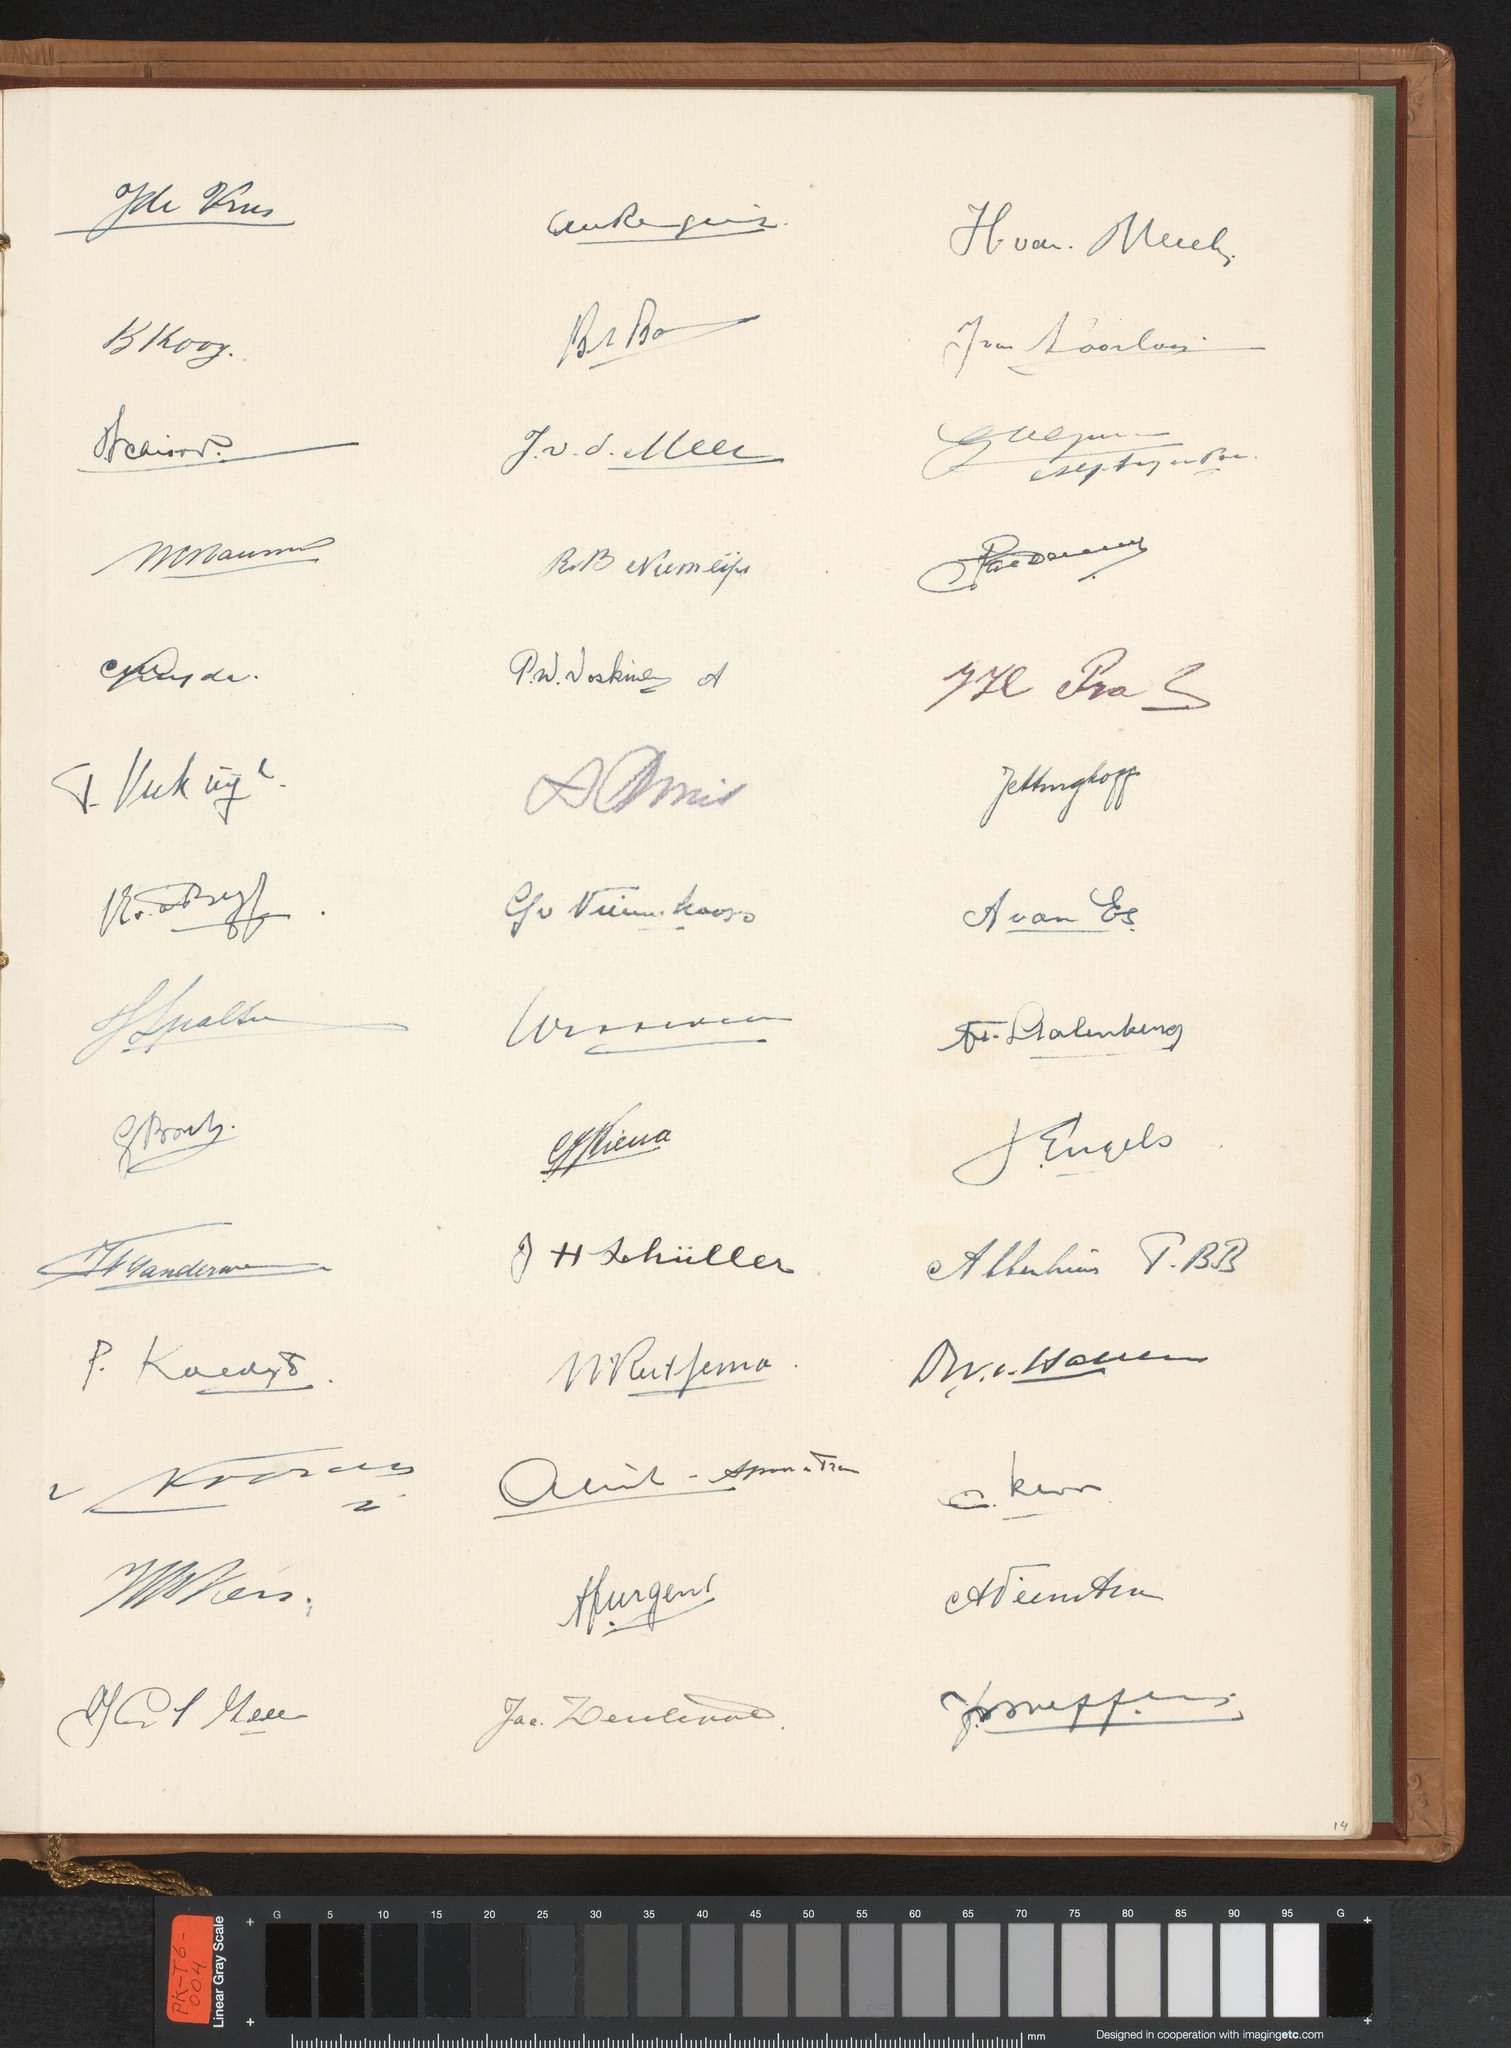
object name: text sheet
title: Blad met handtekeningen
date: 1949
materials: ink, paper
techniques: handwriting, pen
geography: netherlands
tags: modern professional organization, trade union, reception, cocktail party, handwriting, written text, amsterdam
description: Blad met handtekeningen van aanwezigen op het afscheidsfeest. Onderdeel van het fotoalbum ter gelegenheid van het afscheid van Evert Kupers als voorzitter van de NVV op 14 juli 1949 in Amsterdam.